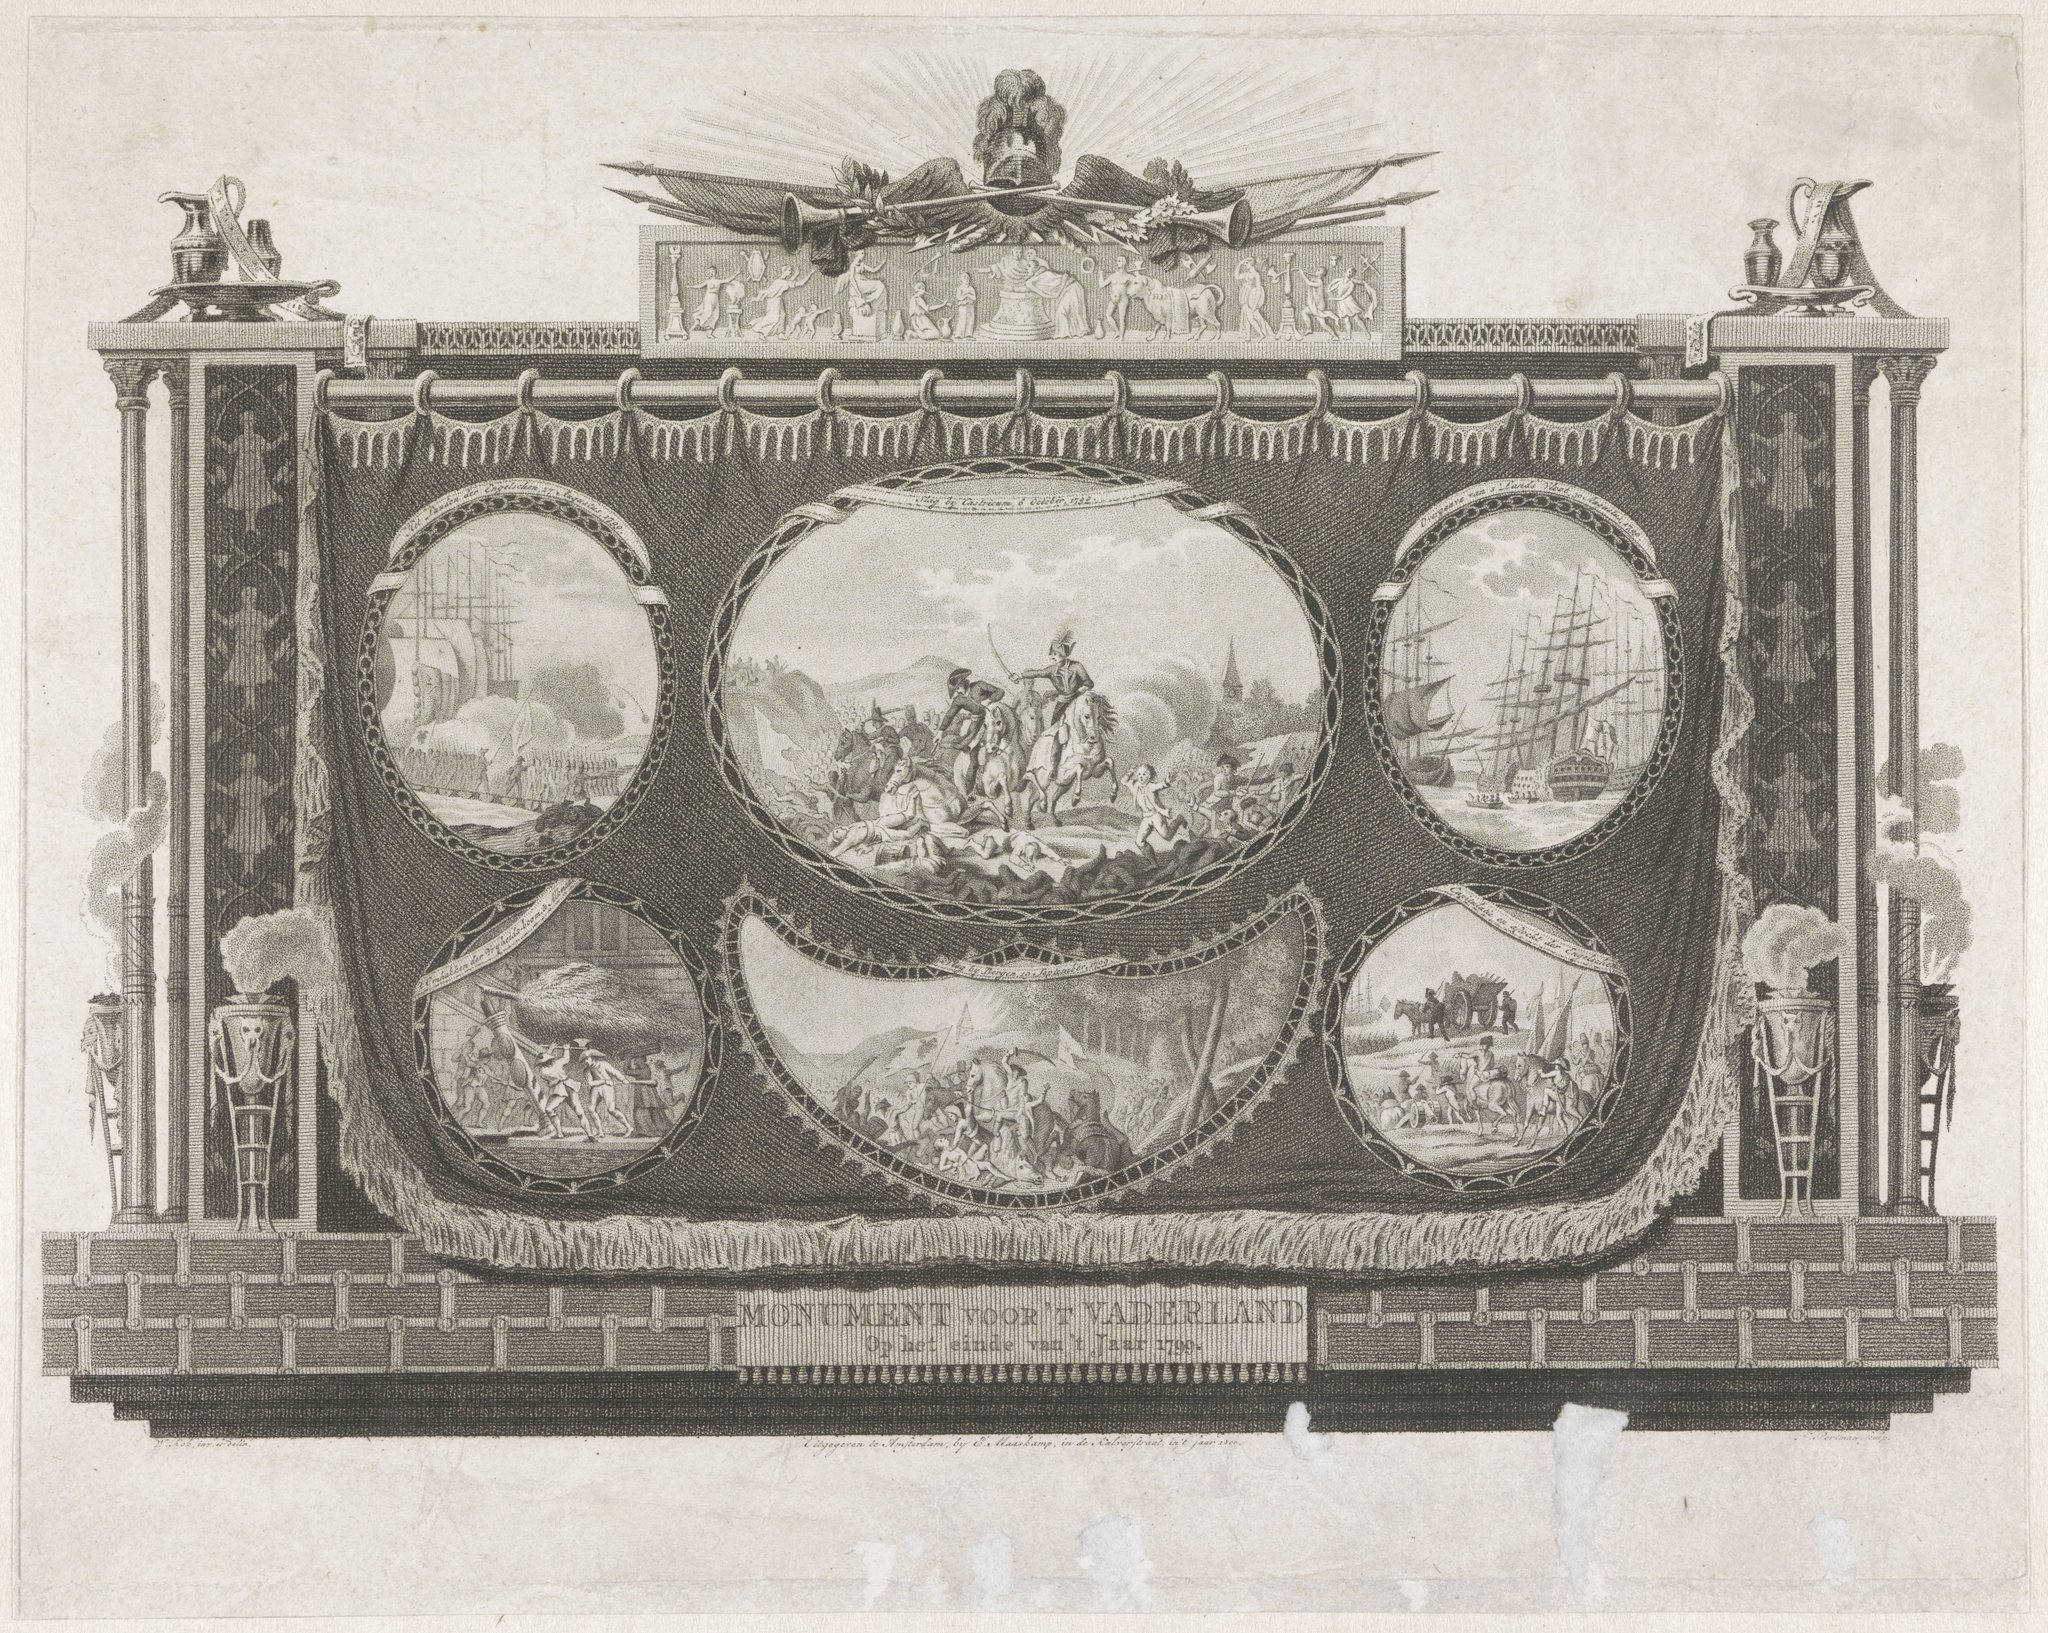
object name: print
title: Monument voor 't Vaderland / Op het einde van 't Jaar 1799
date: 1800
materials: paper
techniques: engraving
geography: netherlands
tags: battle (+ land forces)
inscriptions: collector's mark: Lugt 2228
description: Monument met banier waarop zes voorstellingen van belangrijke gebeurtenissen in het jaar 1799, voornamelijk uit de Brits-Russische expeditie naar Noord-Holland.